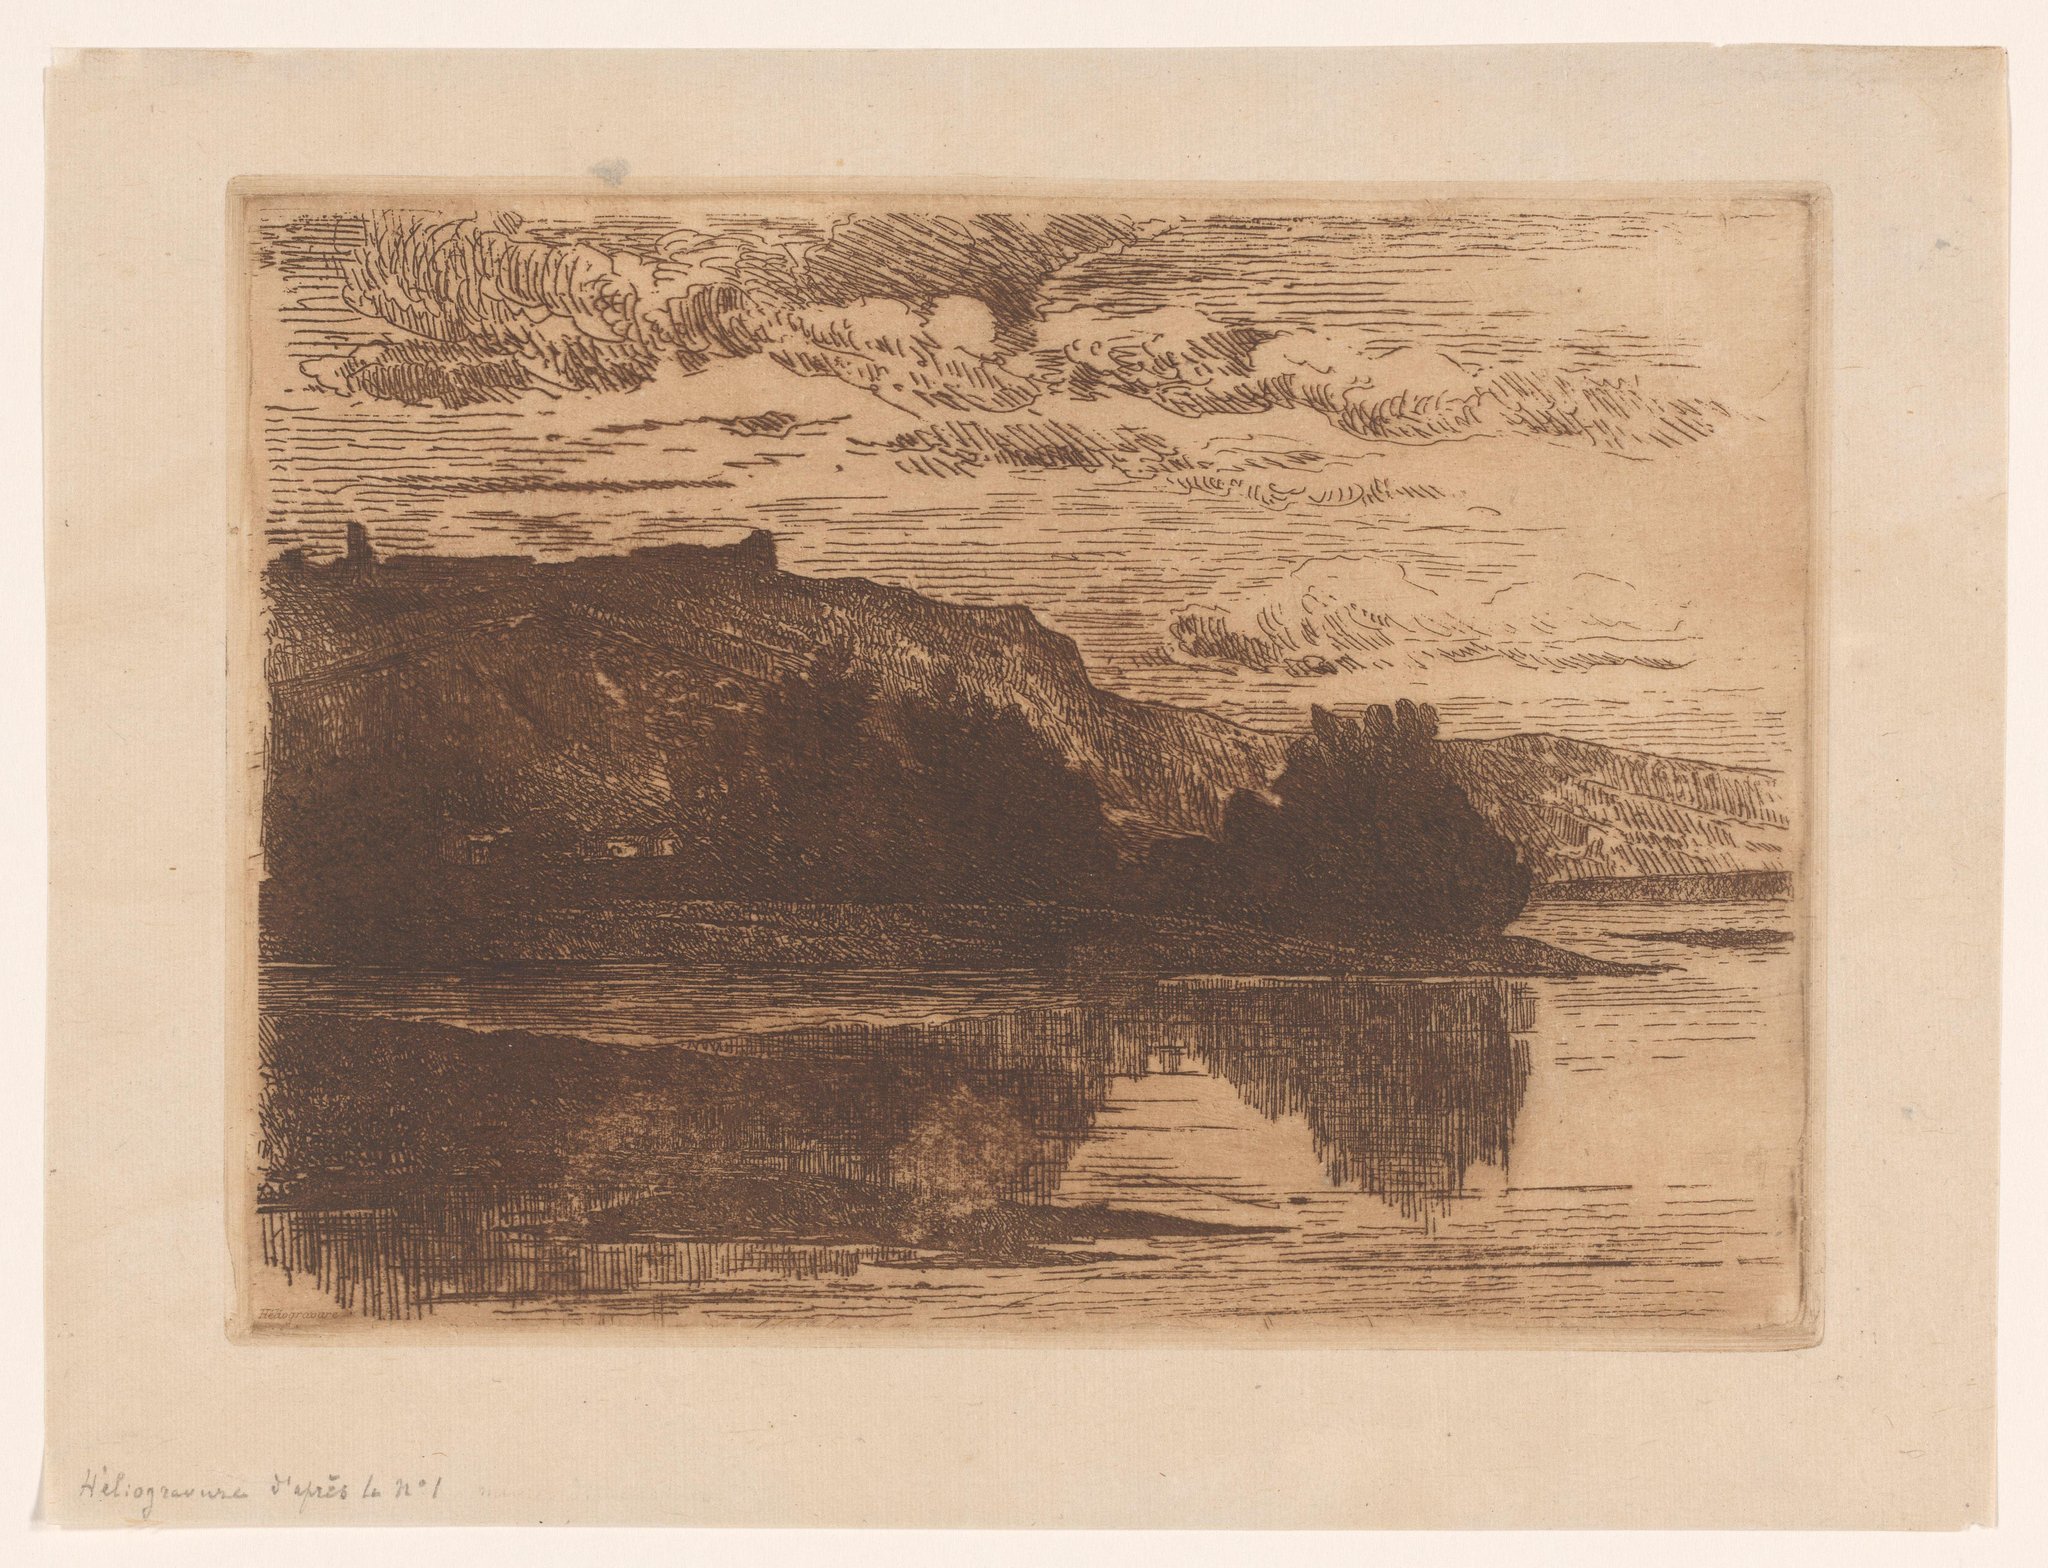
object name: print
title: Ruïnes van kasteel Poilvache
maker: carel nicolaas storm van s-gravesande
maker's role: draughtsman, print maker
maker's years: 1841-1924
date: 1871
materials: paper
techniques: photoaquatint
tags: landscape with ruins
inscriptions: collector's mark: Lugt 2228, inscription: ‘Heliogravure d'après le no 1’